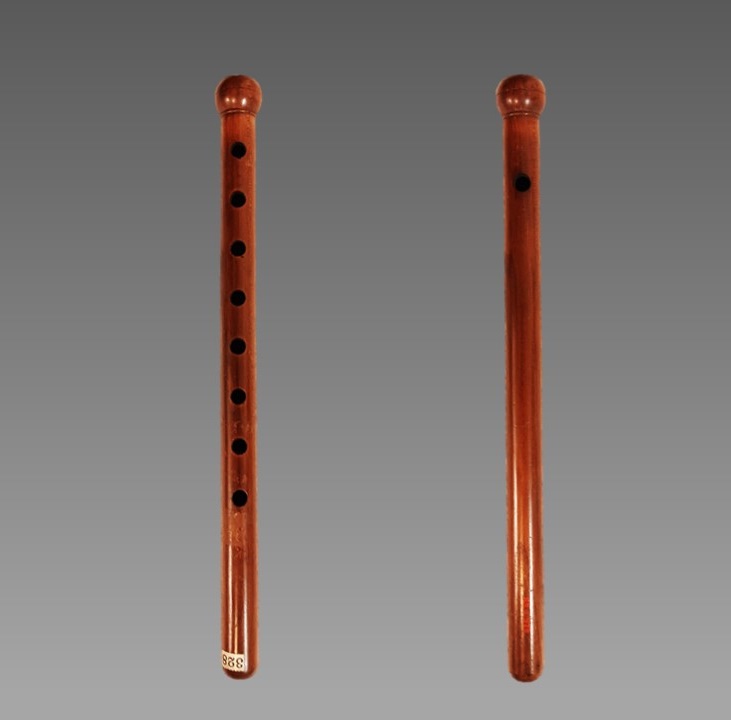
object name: bālābān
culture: azerbaijani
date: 1867-1900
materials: wood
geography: iran